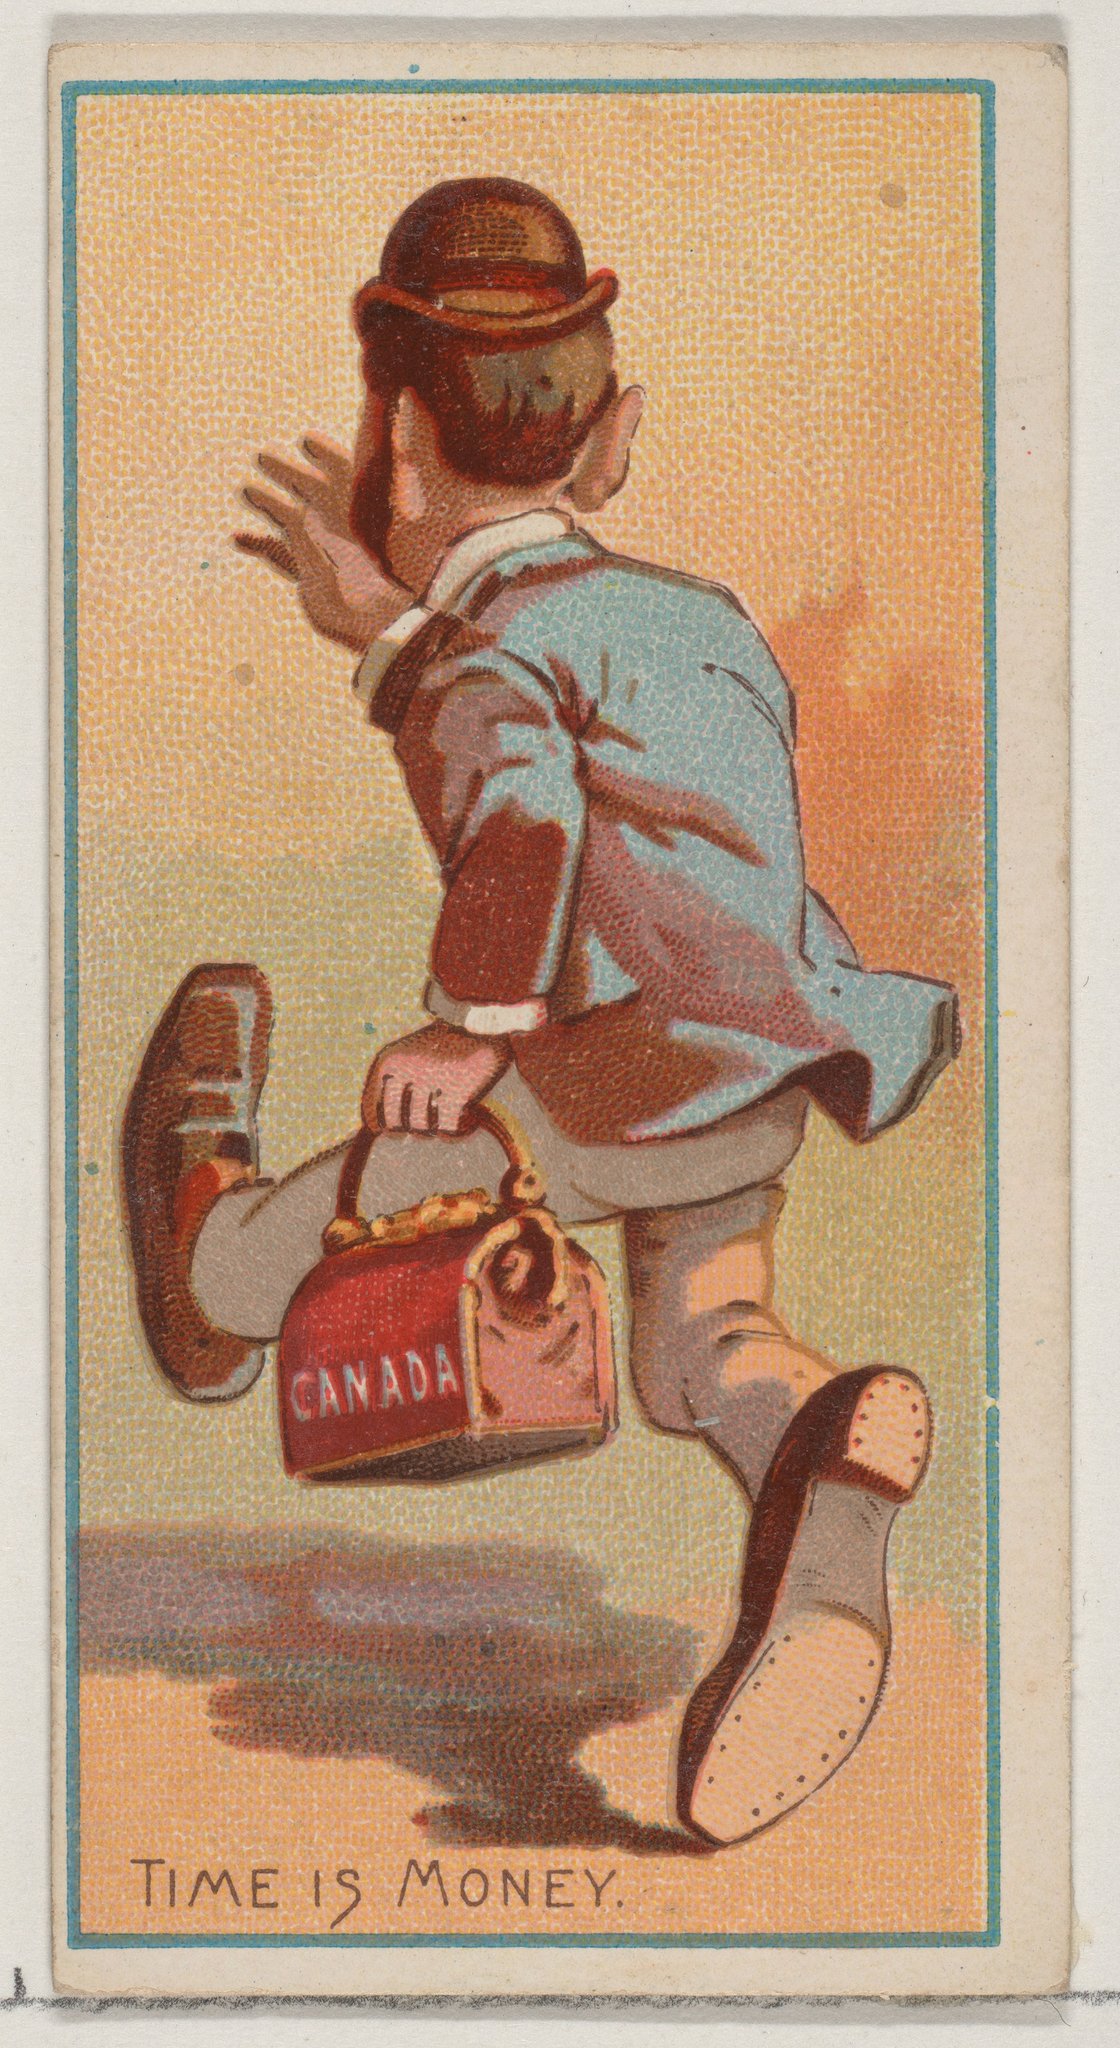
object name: print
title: Time is Money, from the Jokes series (N87) for Duke brand cigarettes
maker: w. duke, sons & co.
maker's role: publisher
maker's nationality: american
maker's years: 1870-1920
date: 1890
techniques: color lithograph